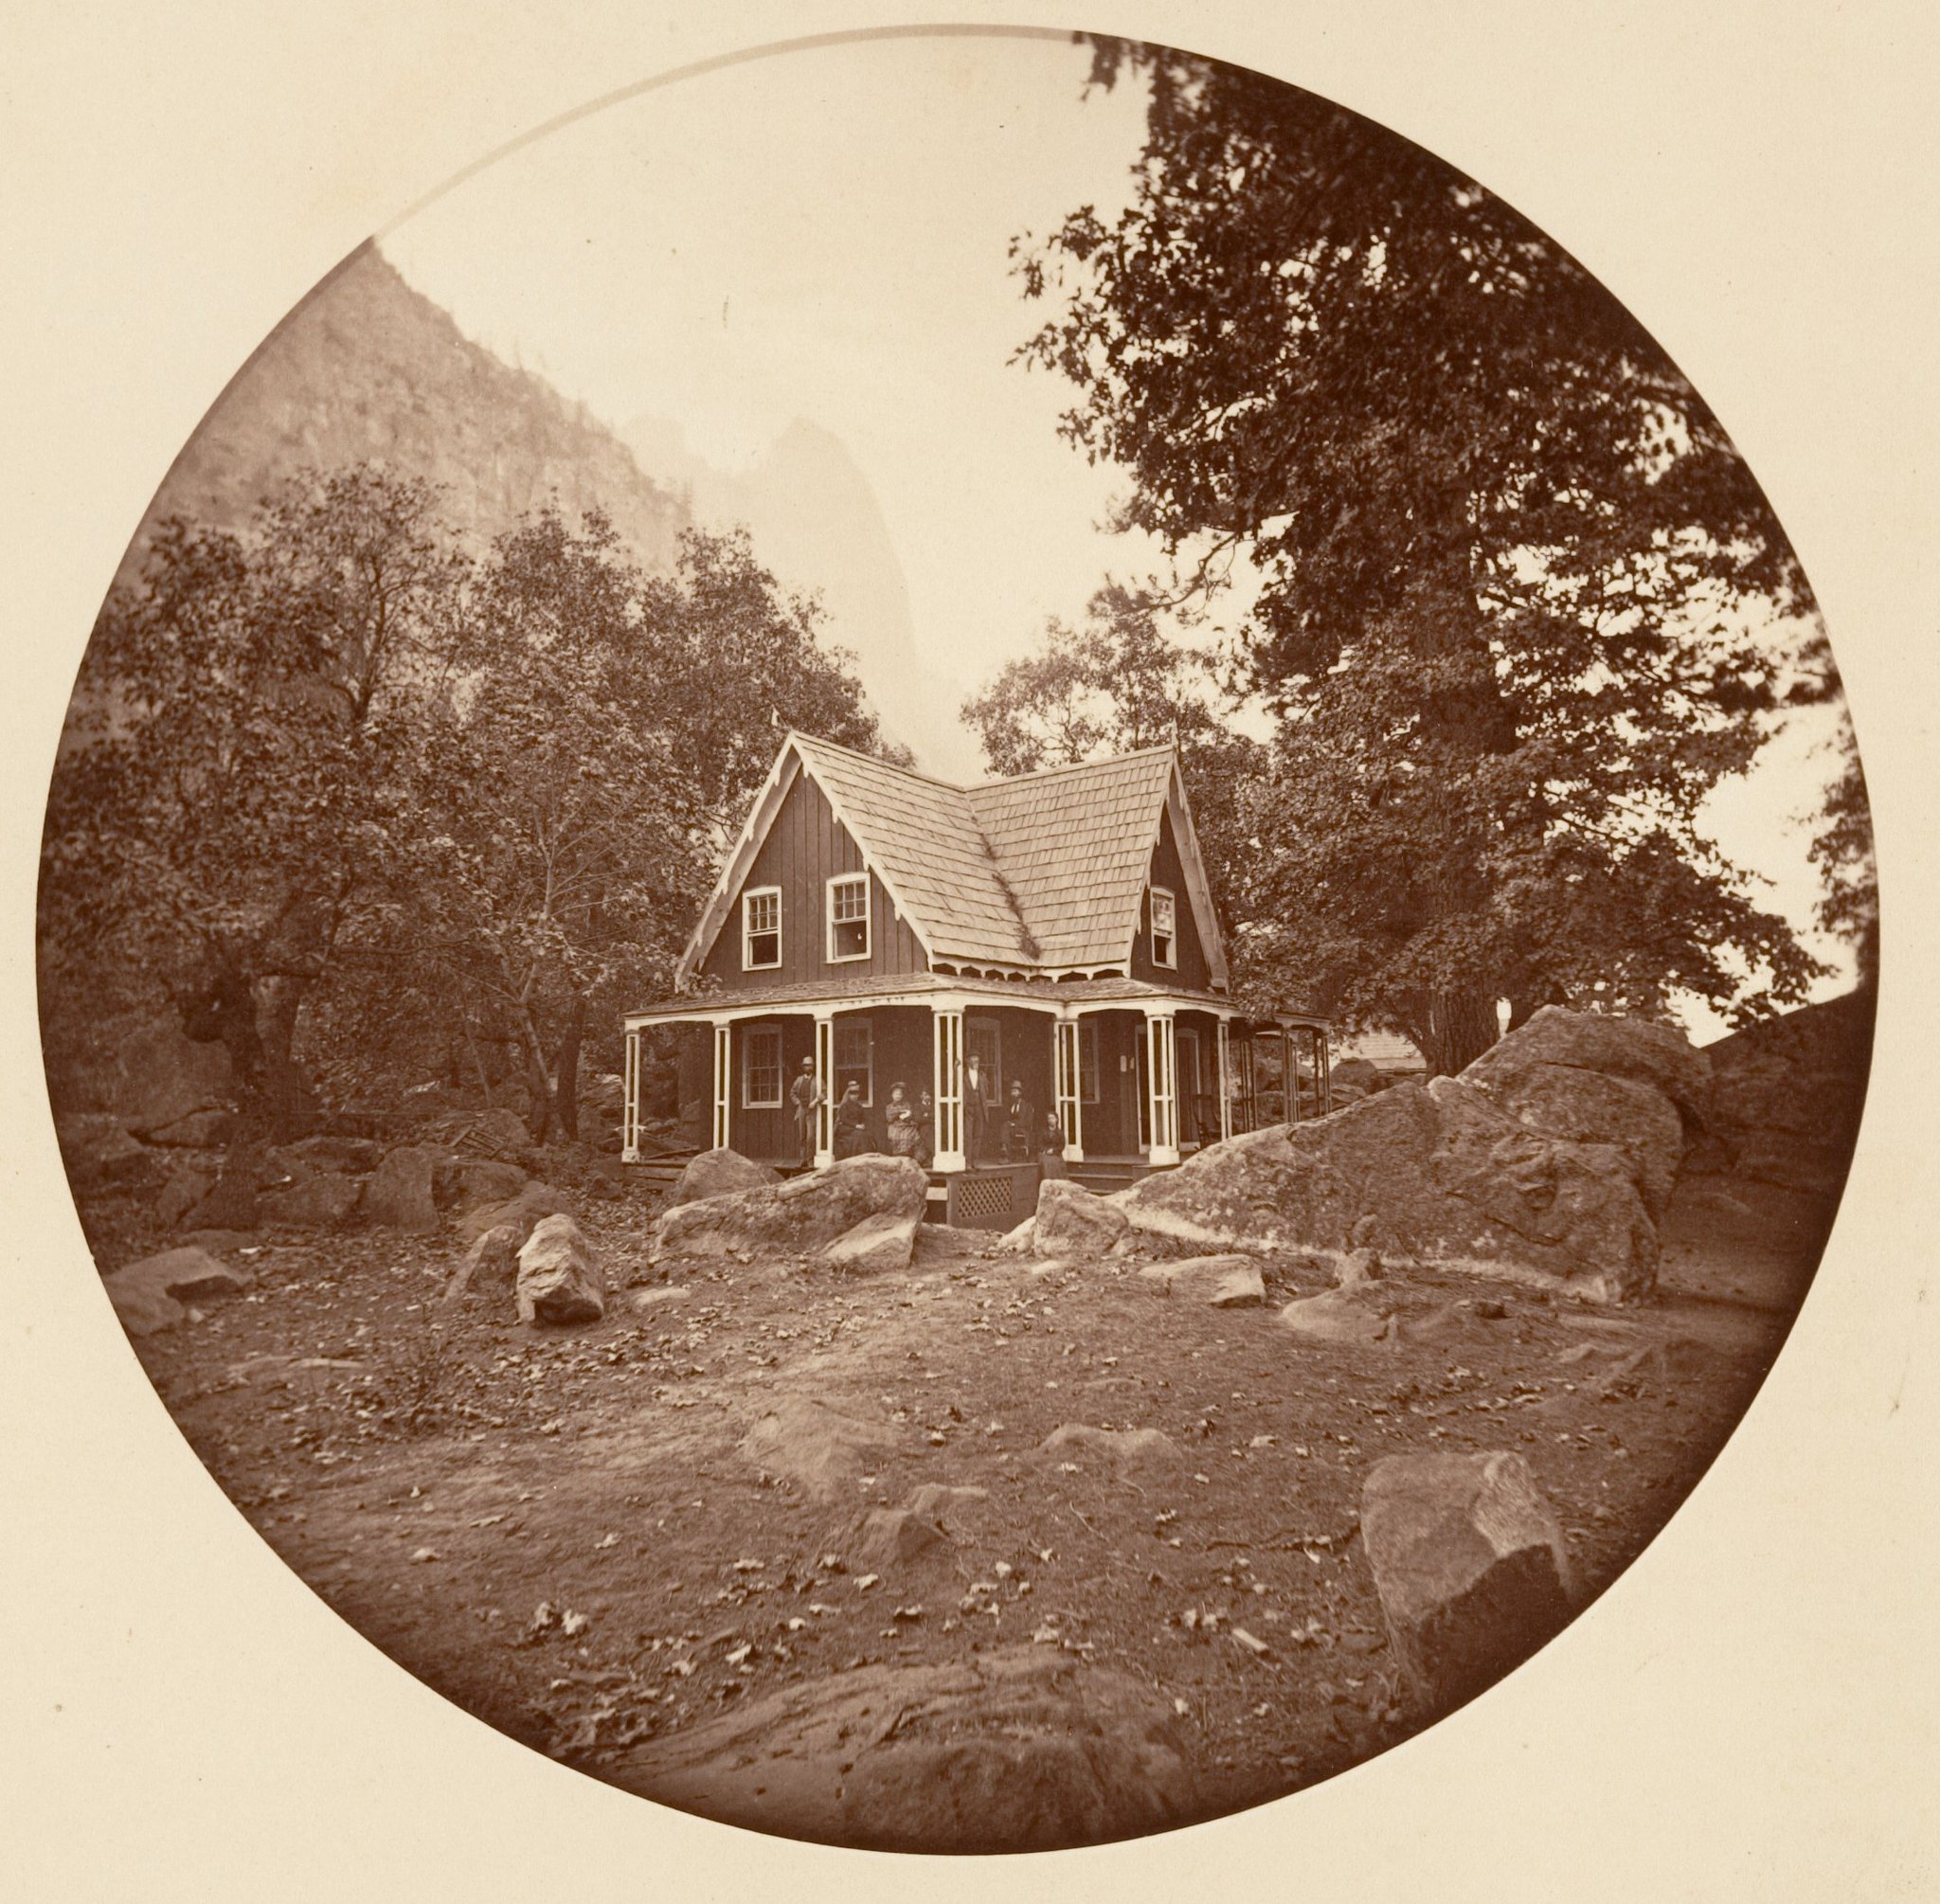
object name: photograph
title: [Yosemite National Park, California]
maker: carleton e. watkins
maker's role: artist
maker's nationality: american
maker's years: 1829-1916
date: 1878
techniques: albumen silver print, glass negative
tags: houses,landscapes